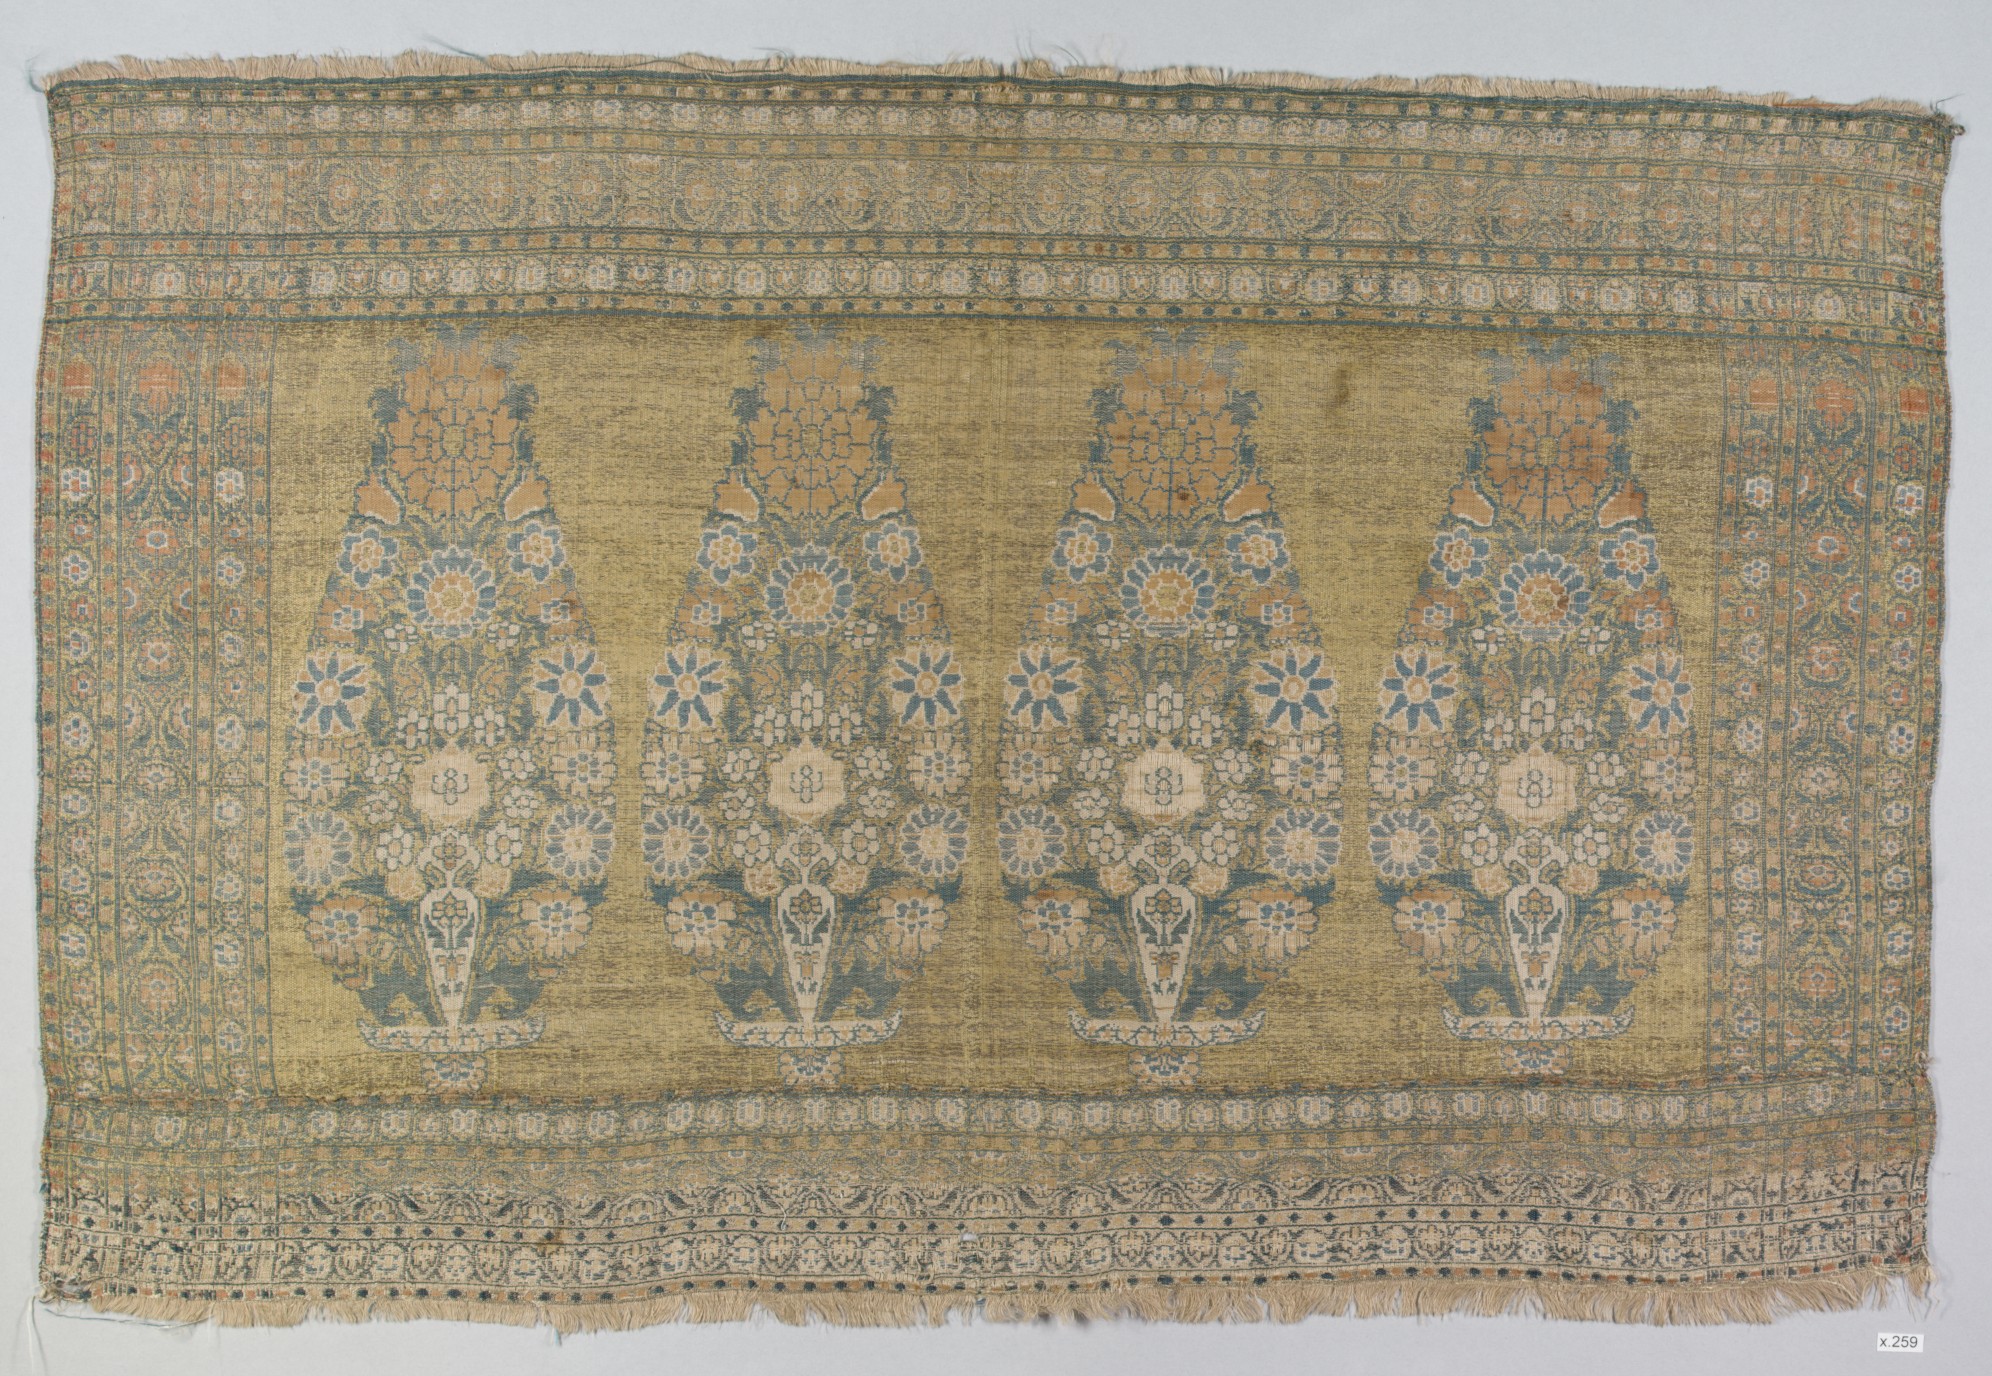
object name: textile fragment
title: Fragment of Sash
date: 1701-1800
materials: metal, silk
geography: iran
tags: flowers